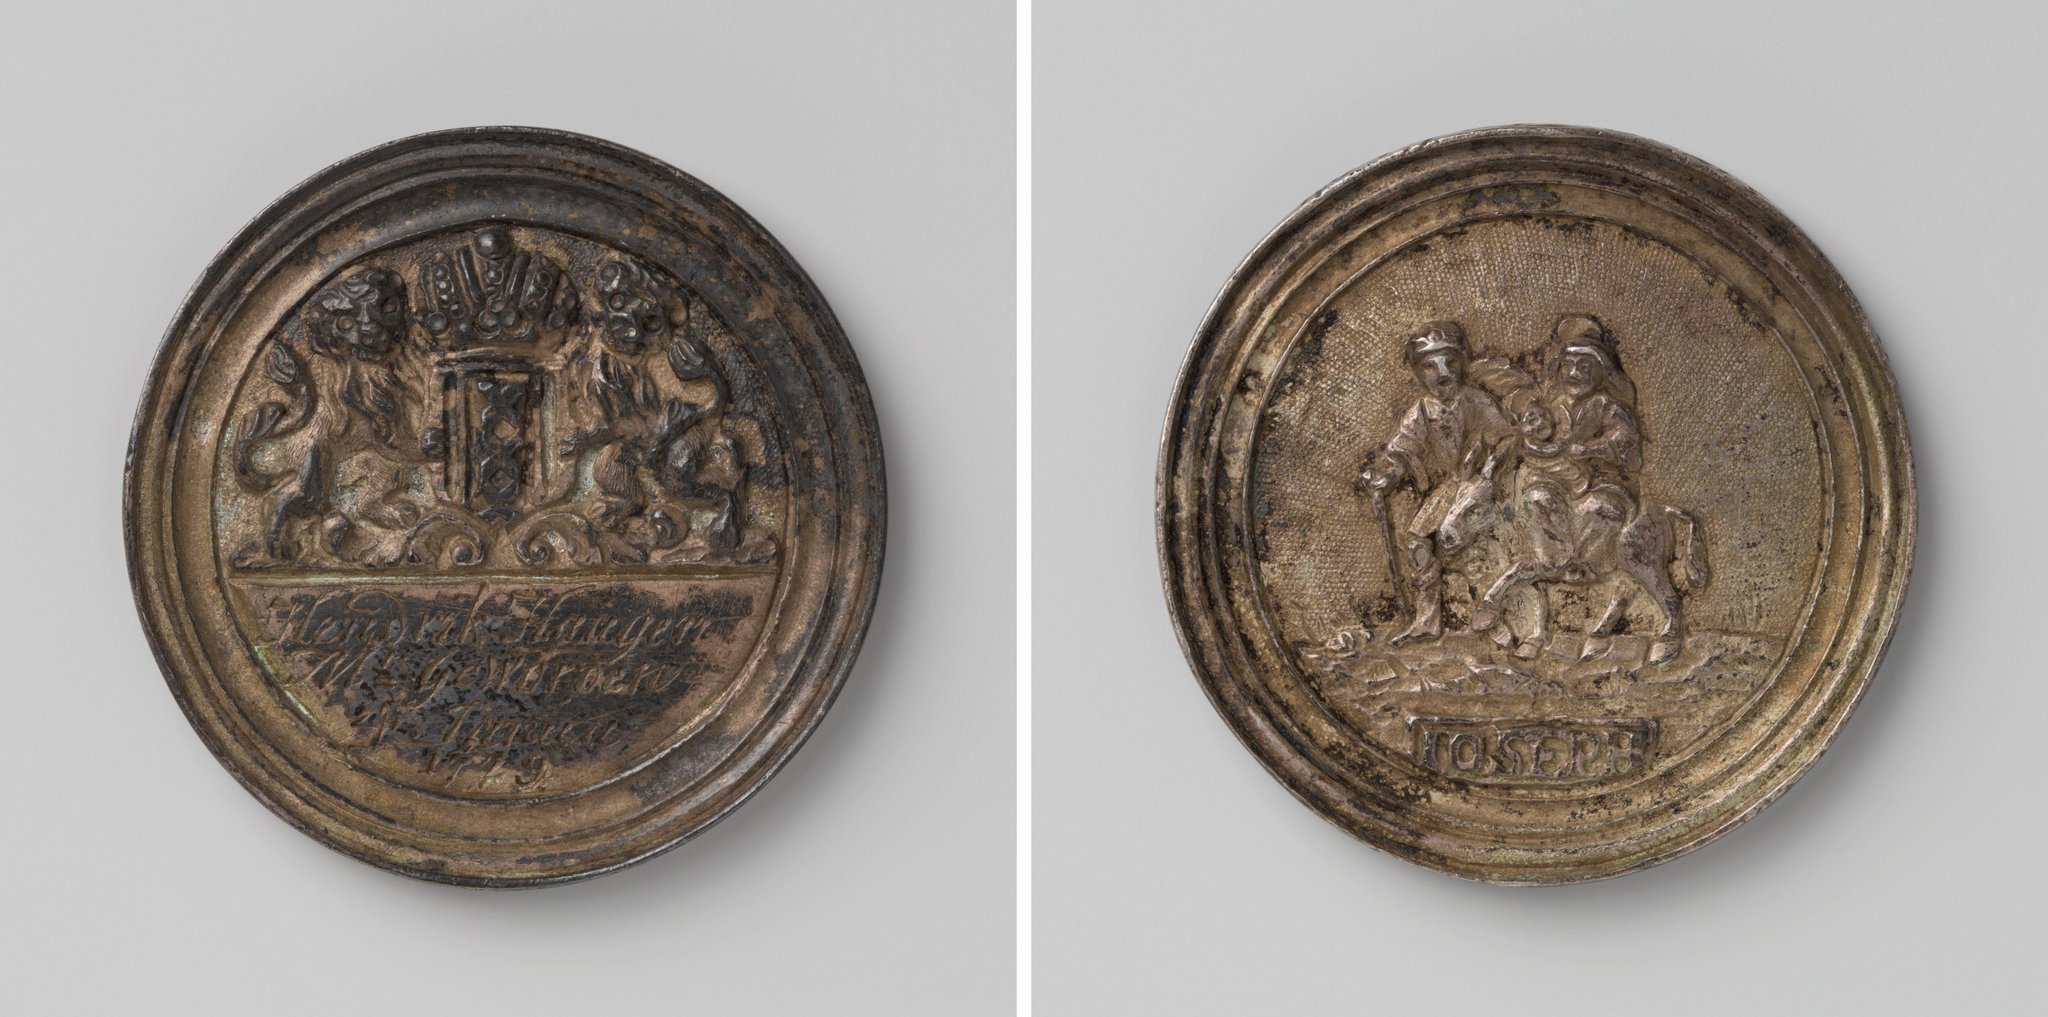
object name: overmanspenning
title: Timmerliedengilde van Amsterdam, gildepenning van Hendrik Haagen, overman en deken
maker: Anonymous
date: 1729-1769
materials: silver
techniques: casting, engraving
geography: amsterdam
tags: amsterdam